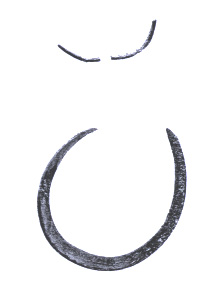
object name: bracelet fragment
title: Bracelet (?) fragments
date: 3300-3100 BCE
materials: shell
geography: egypt